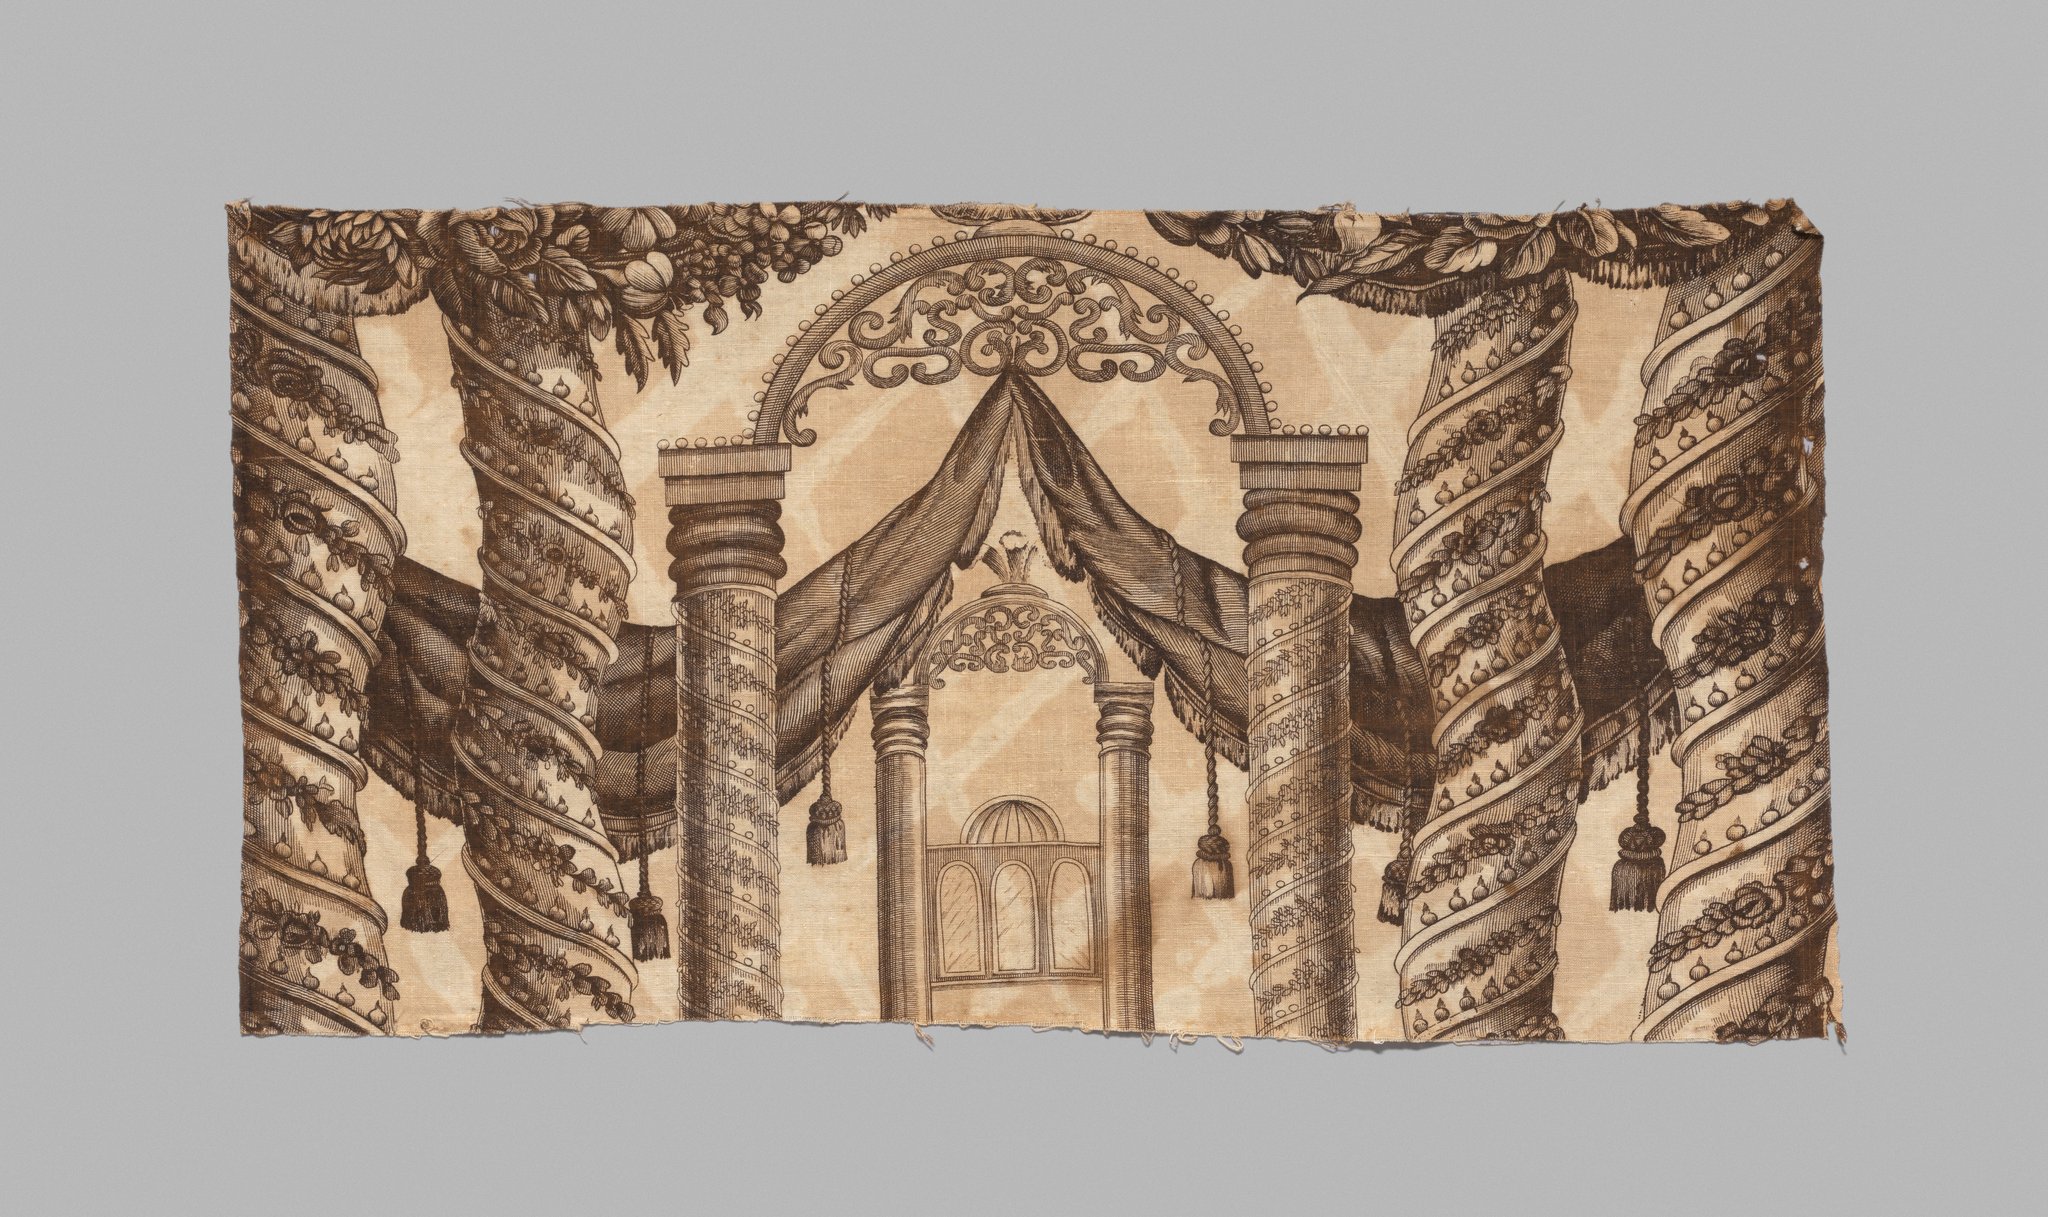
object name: fragment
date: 1801-1850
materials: cotton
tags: columns,garlands